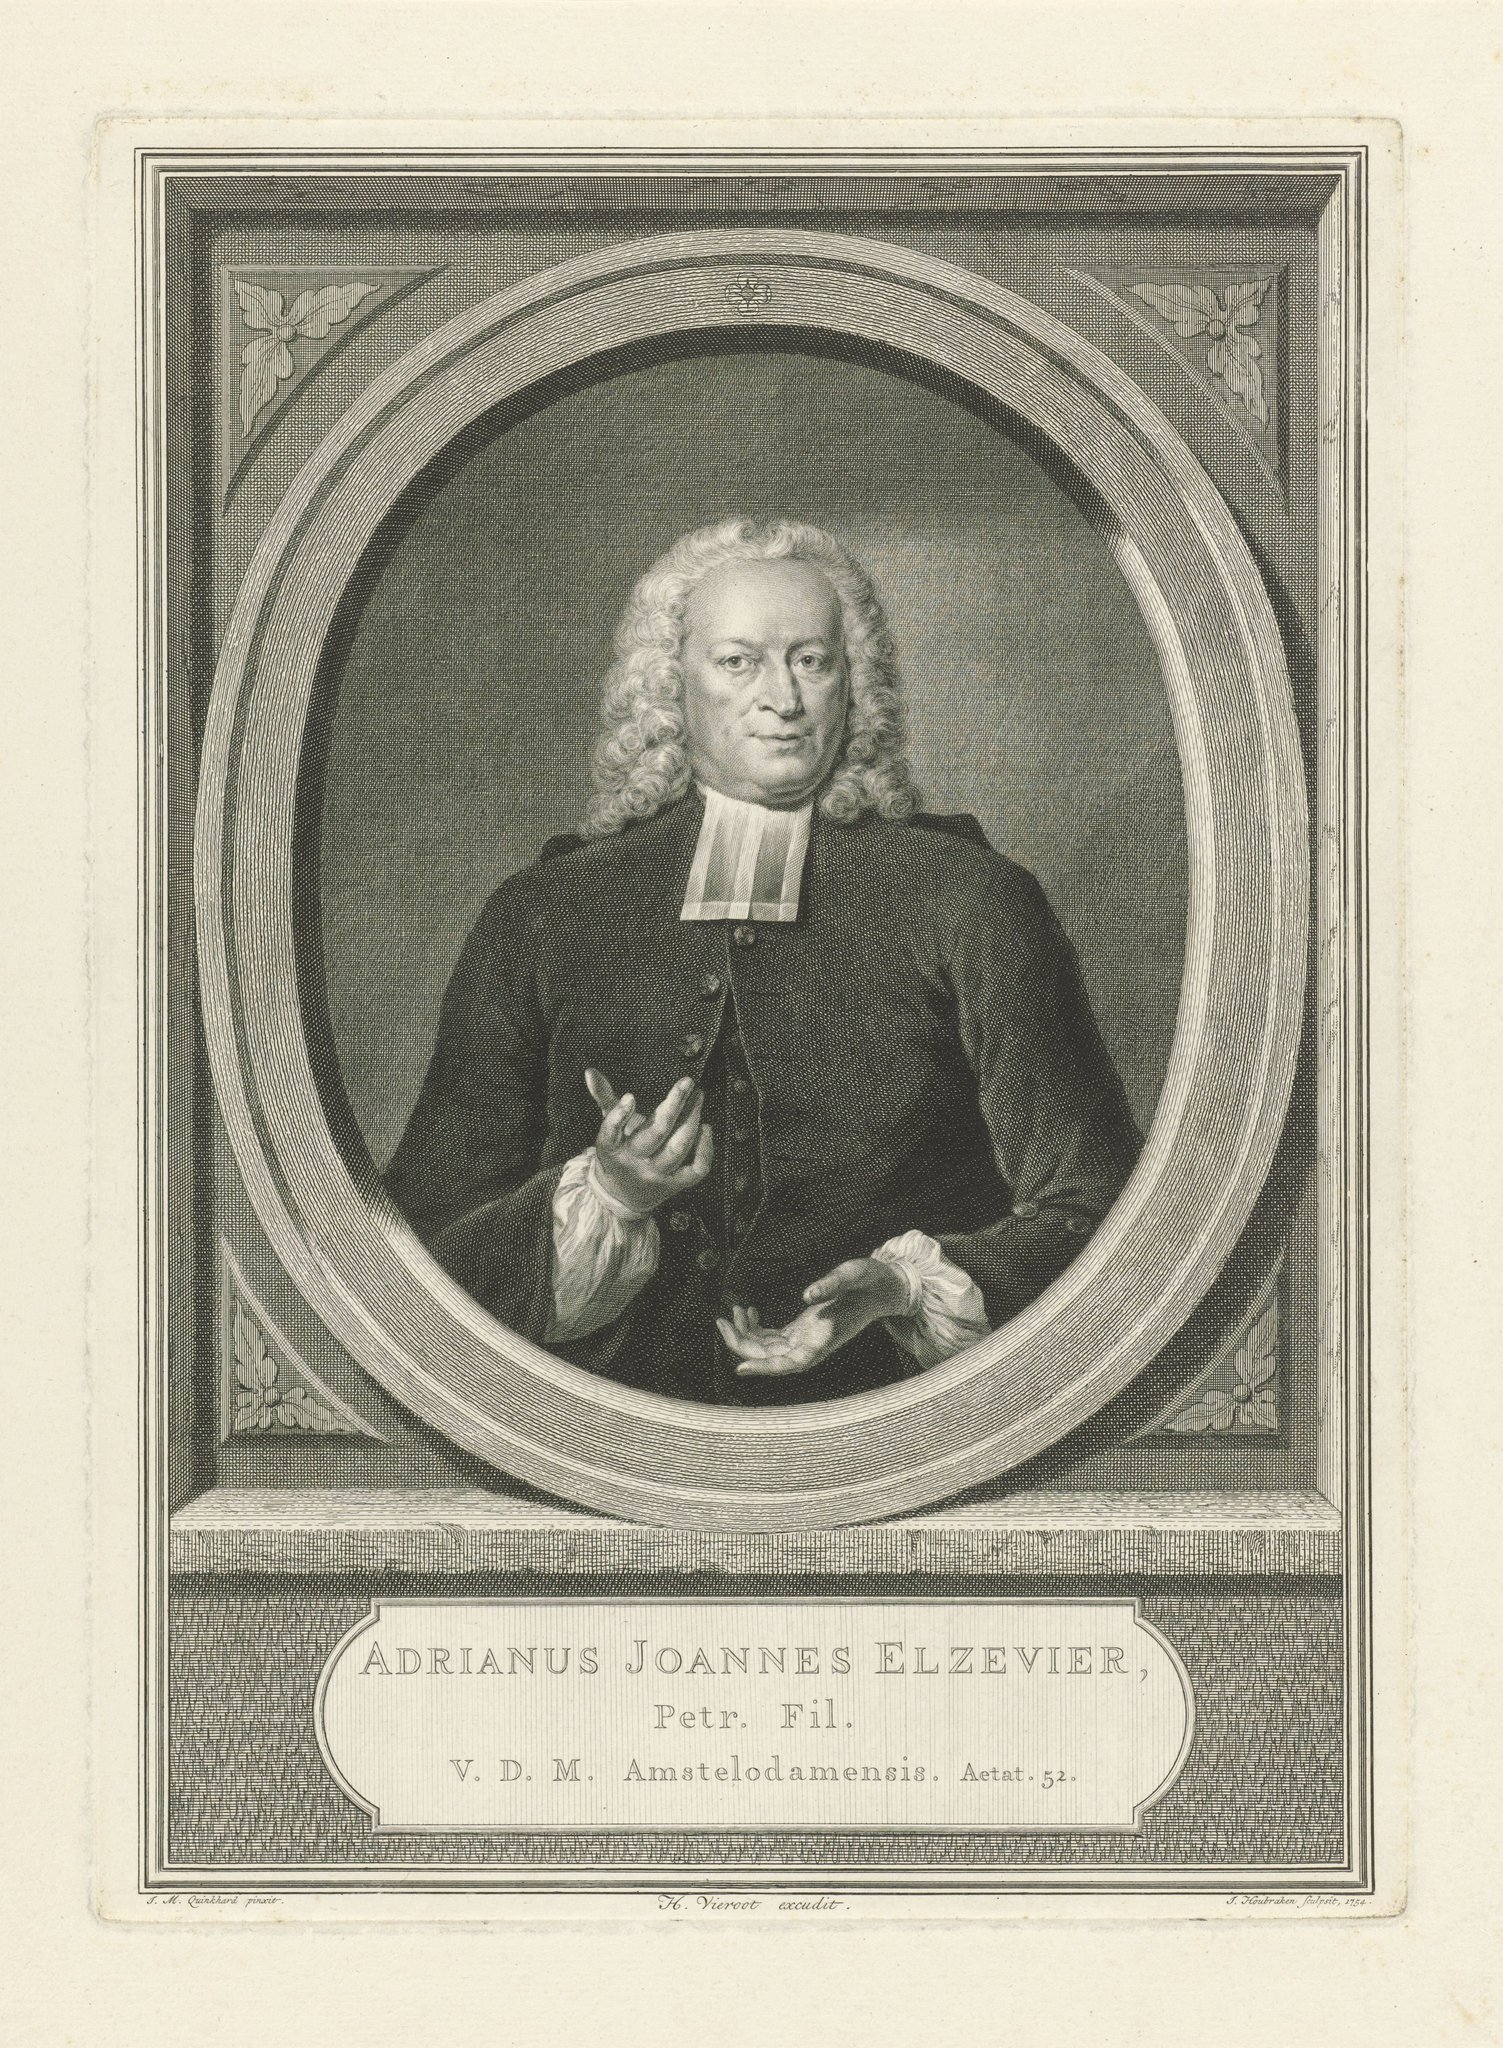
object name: print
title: Adrianus Joannes Elzevier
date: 1754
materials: paper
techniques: engraving, etching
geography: amsterdam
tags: adriaan johannes elzevier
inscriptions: collector's mark: Lugt 2228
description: Portret ten halven lijve van Adriaan Johannes Elzevier op 52-jarige leeftijd in een ovaal. Onder het portret een plint waarop een cartouche met zijn naam en gegevens in drie regels in het Latijn.